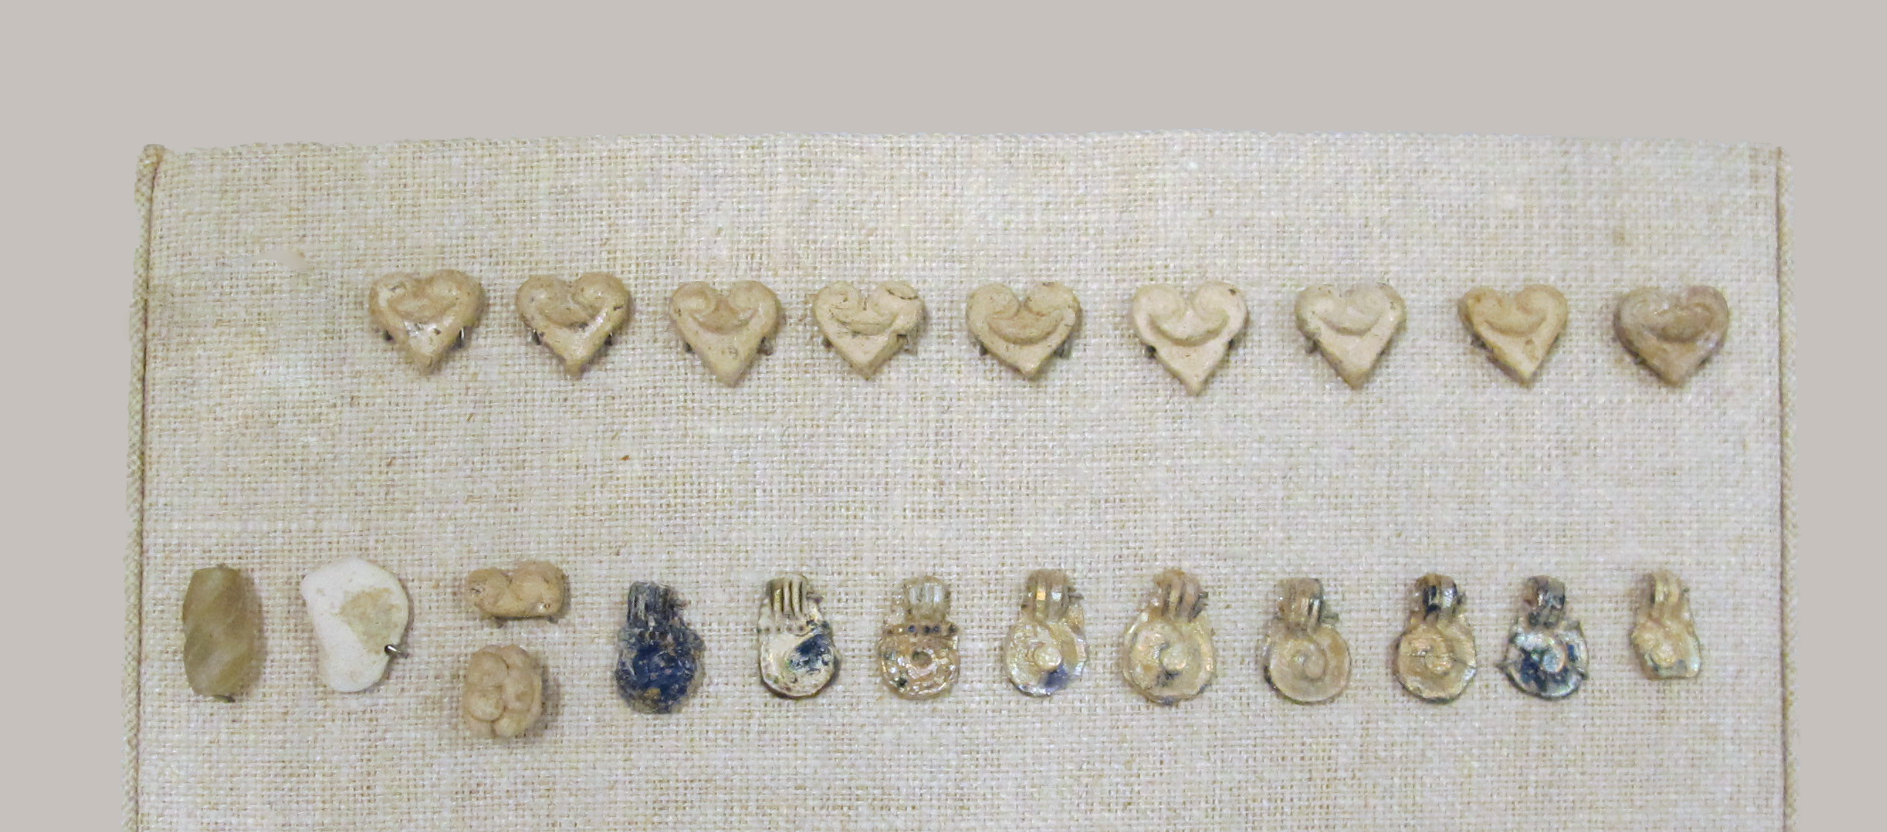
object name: necklace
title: Glass ornaments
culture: aegean, helladic or mycenaean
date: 1400-1200 BCE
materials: glass